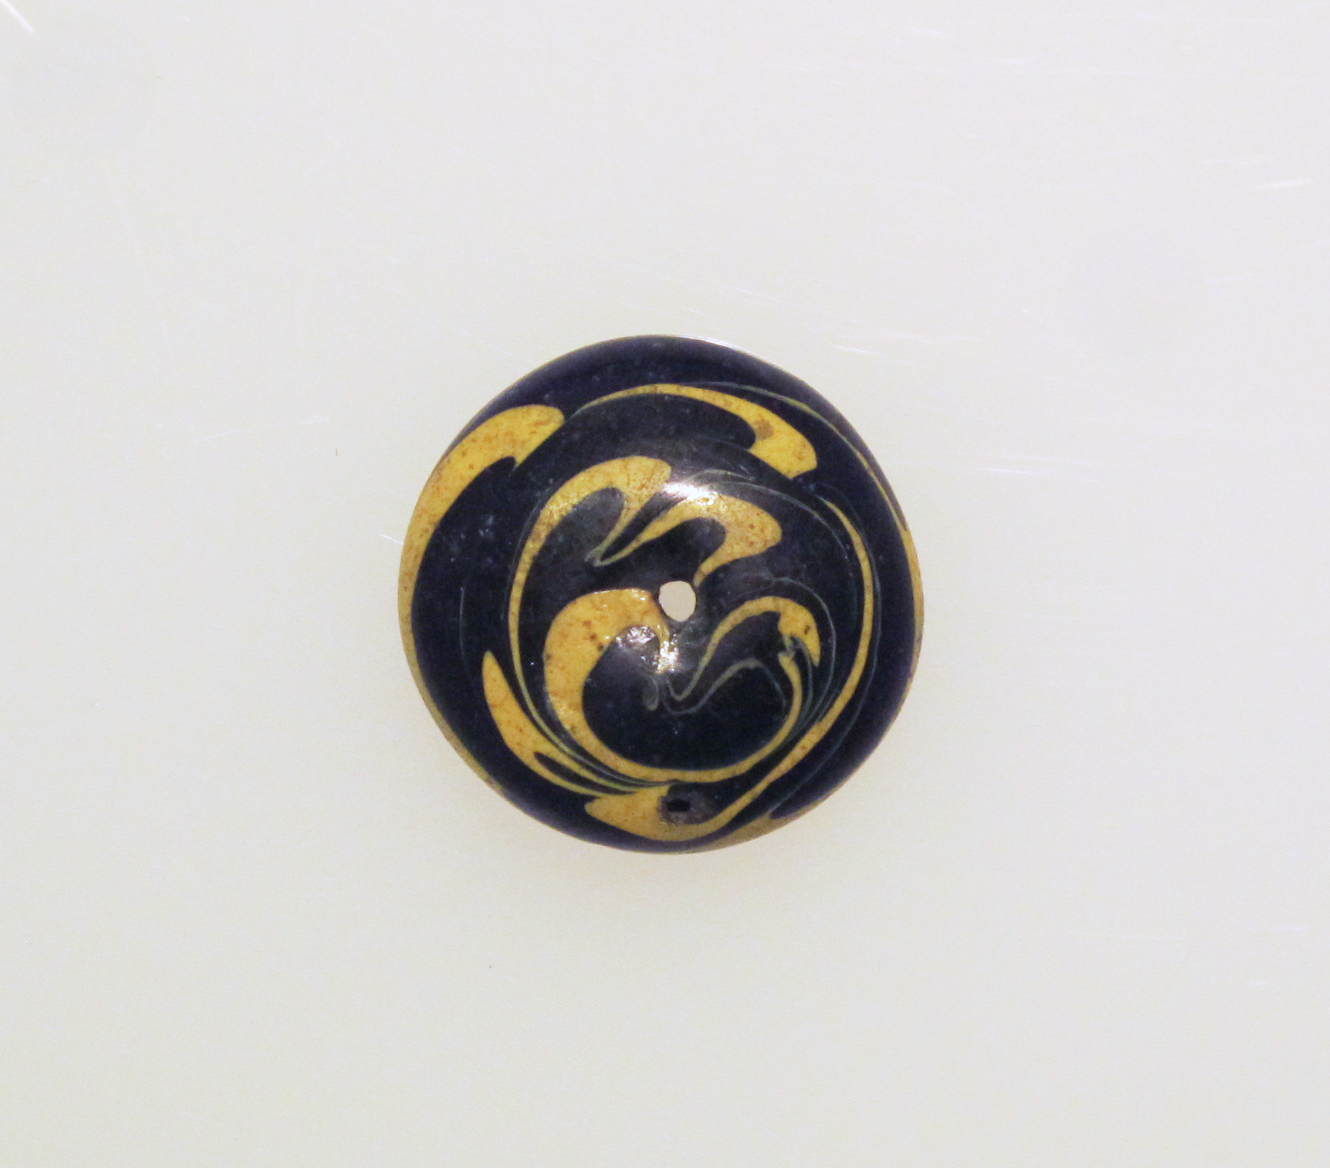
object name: pinhead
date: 7000 BCE-330 CE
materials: glass